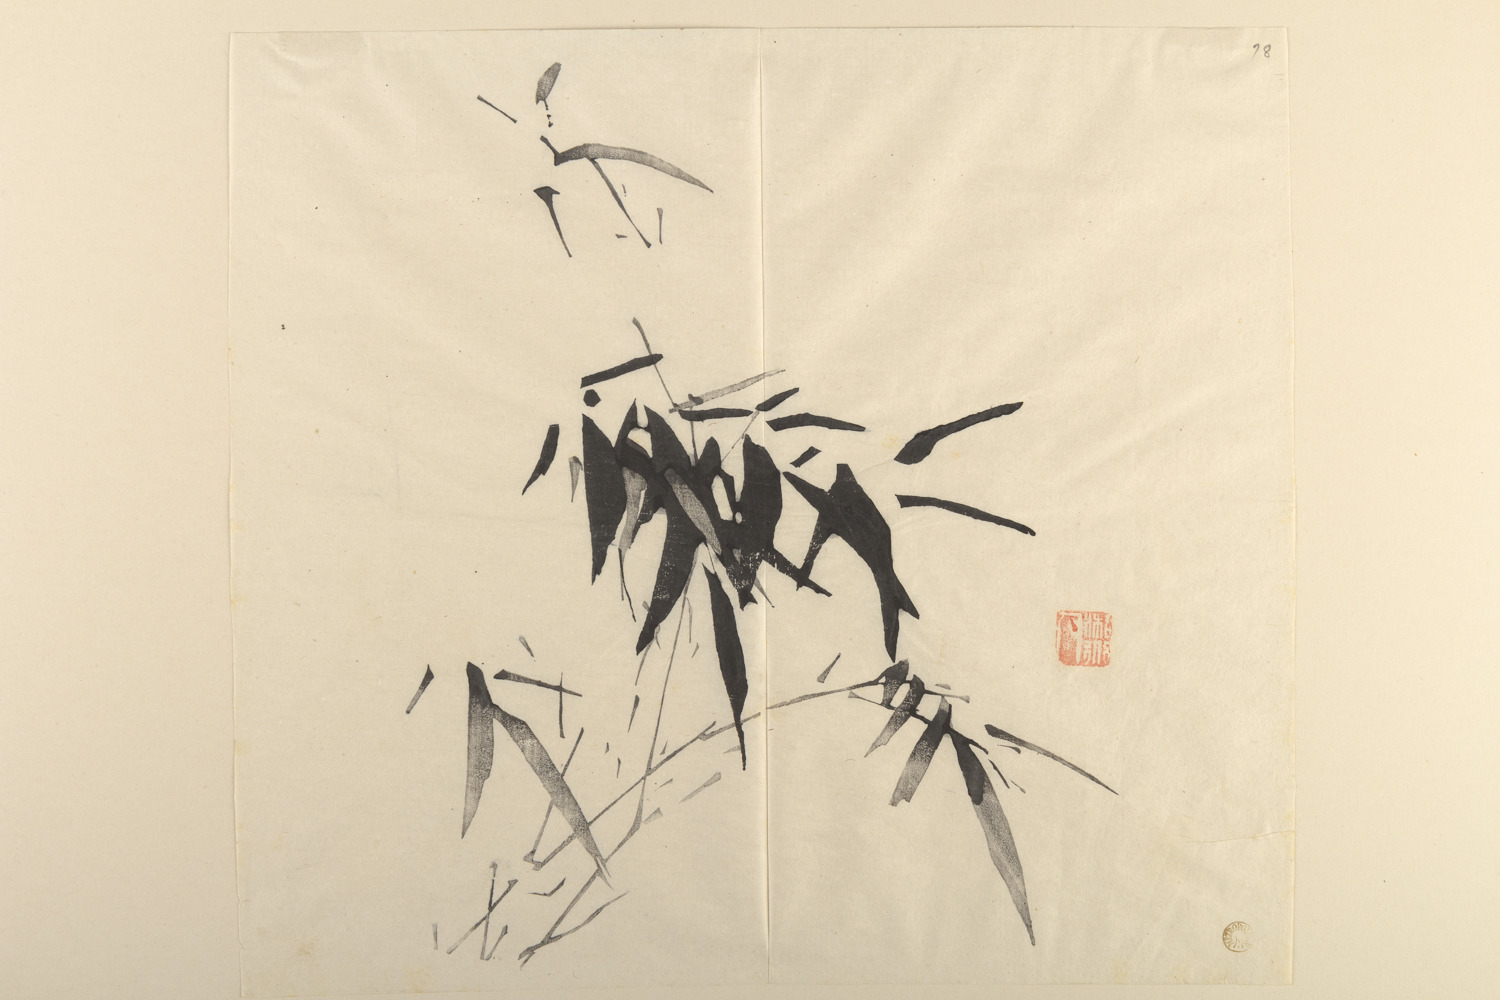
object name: print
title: Page from Shi Zhu Zhai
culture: chinese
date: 1736-1795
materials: ink, paper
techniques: polychrome, woodblock print